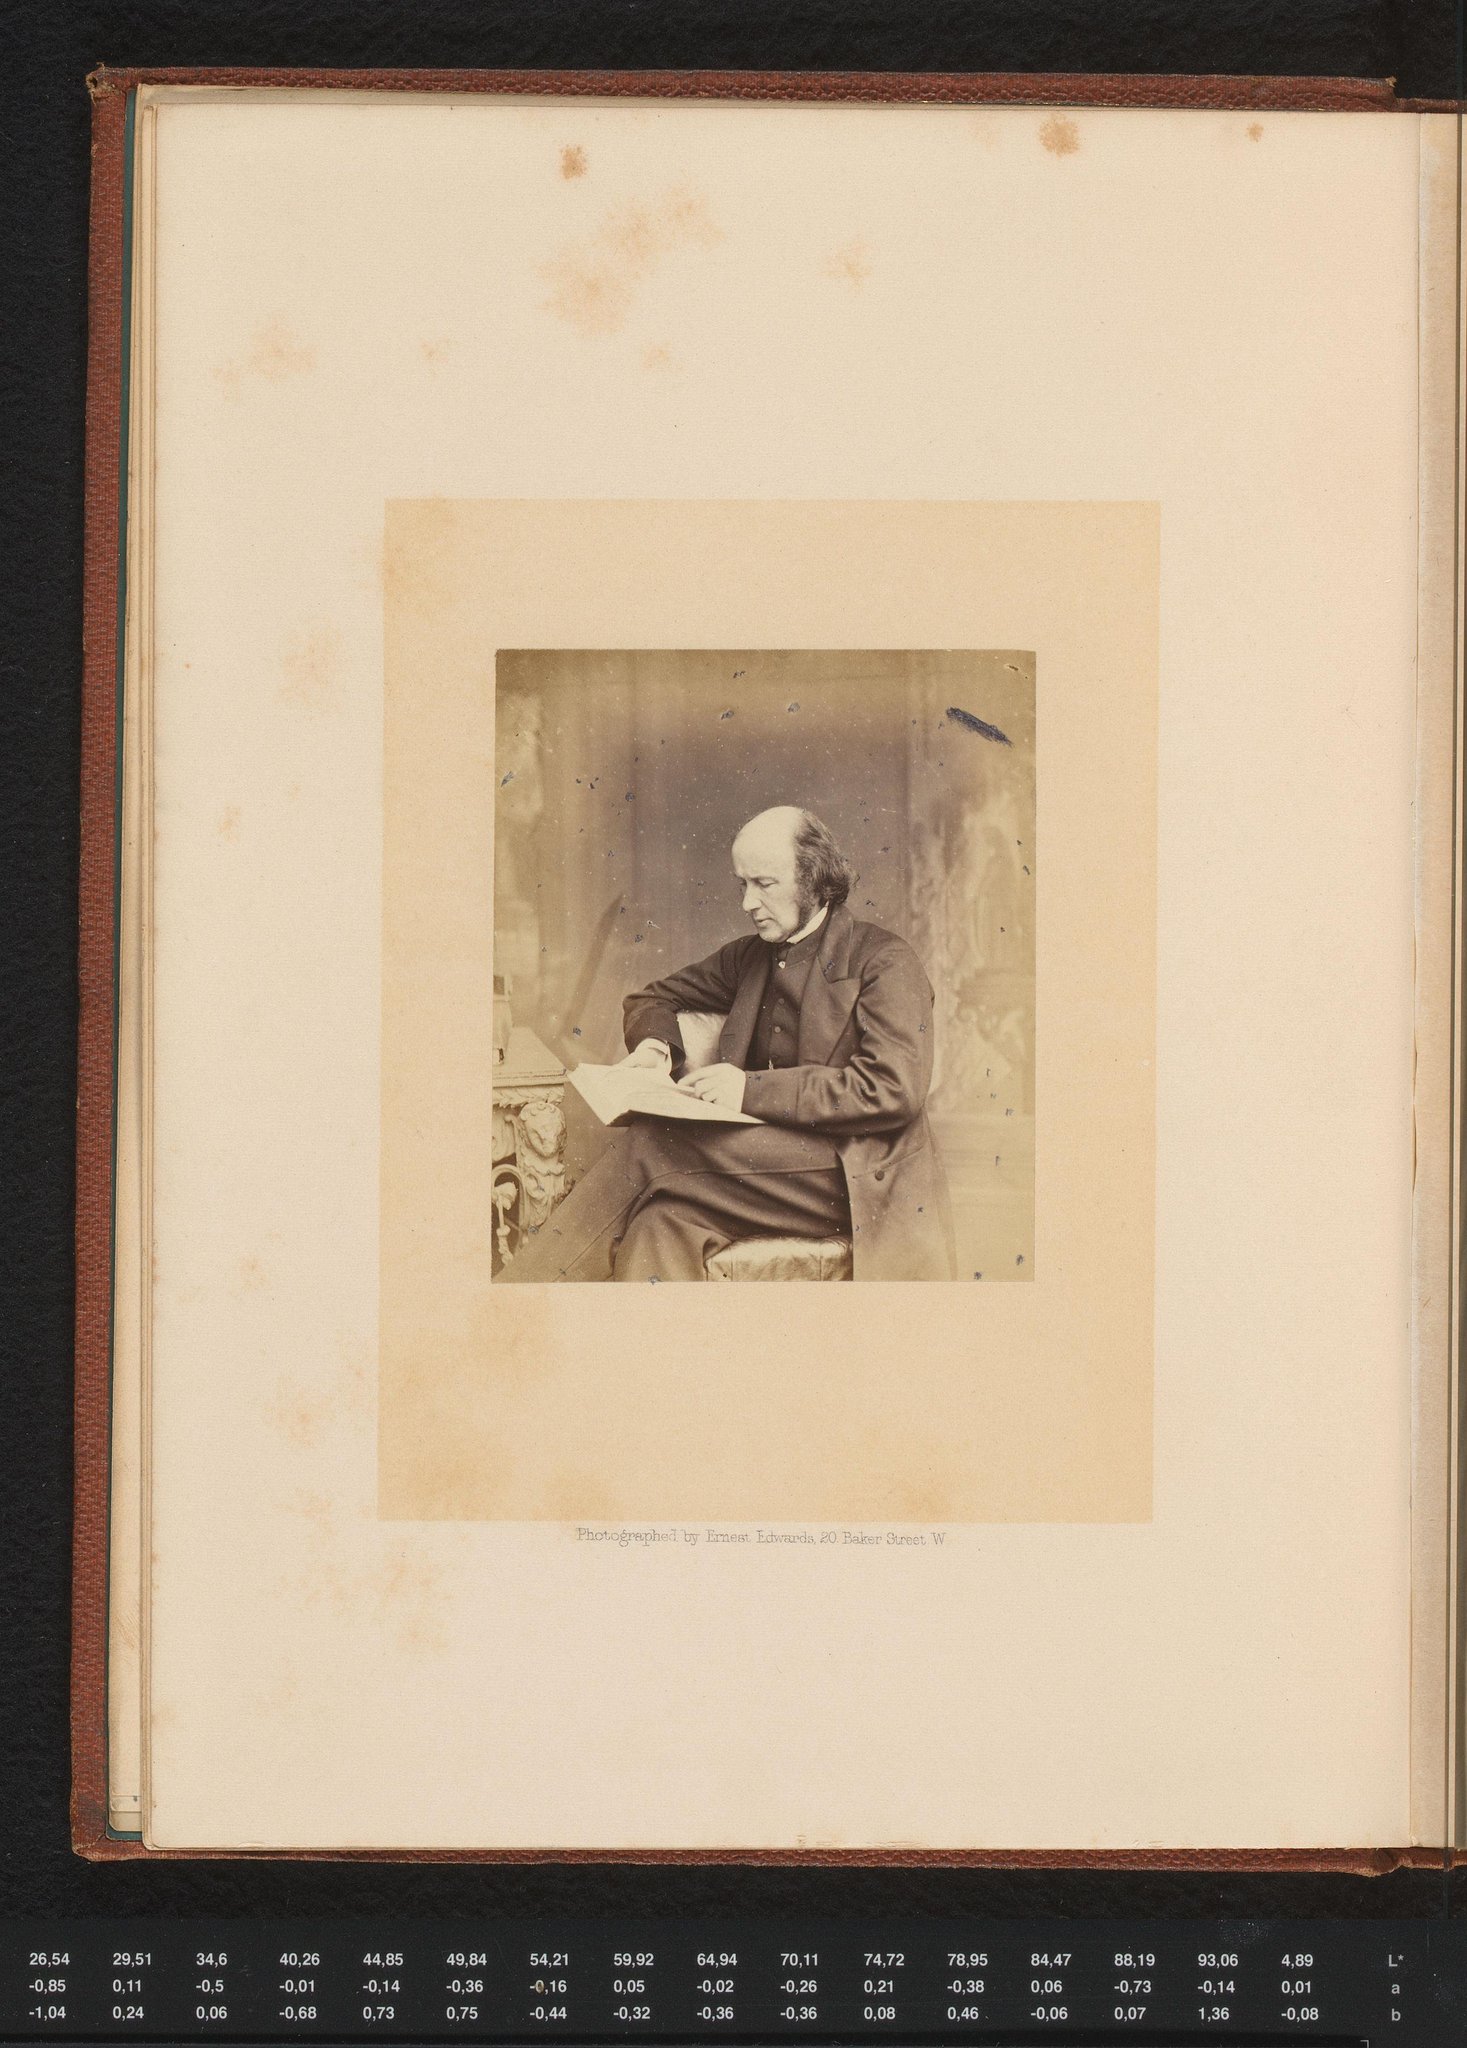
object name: page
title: Portret van de arts Henry Wentworth Acland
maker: ernest edwards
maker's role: fotograaf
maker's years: 1837-1903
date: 1861-1866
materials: paper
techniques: albumen print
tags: physician, doctor (+ portrait of scholar, scientist)